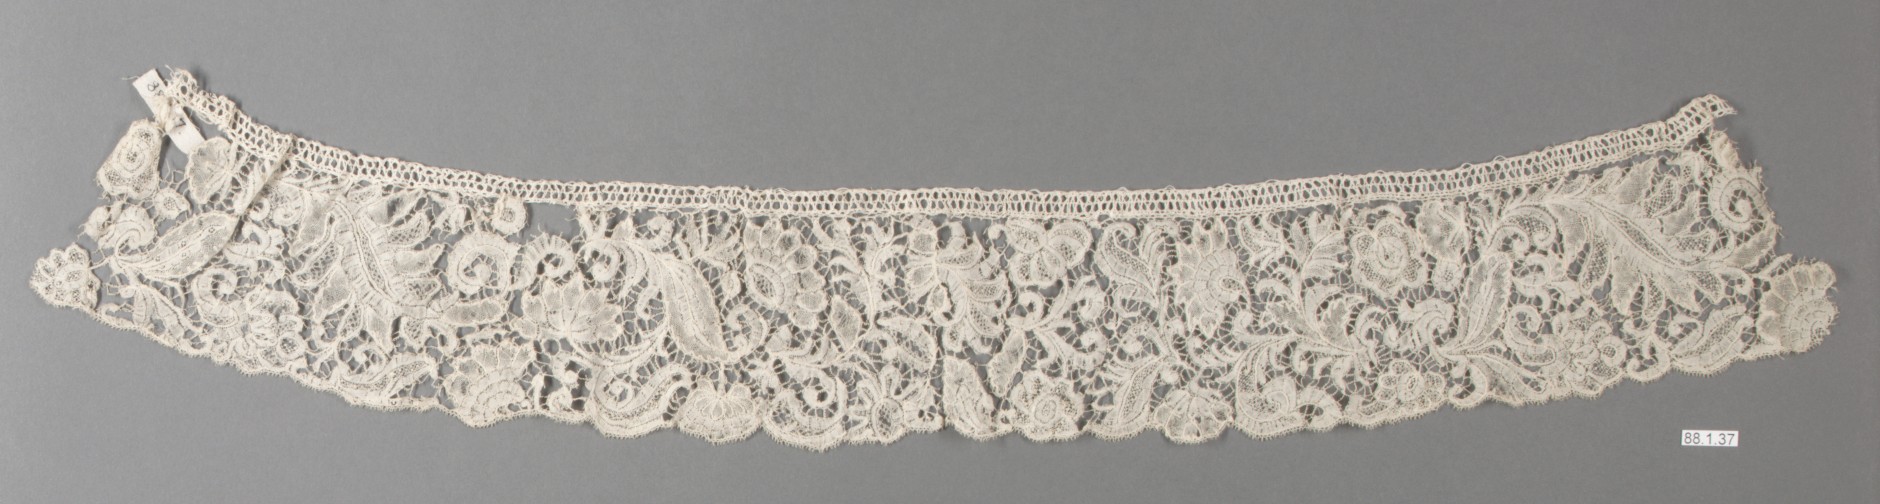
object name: piece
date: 1701-1800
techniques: lace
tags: flowers,leaves